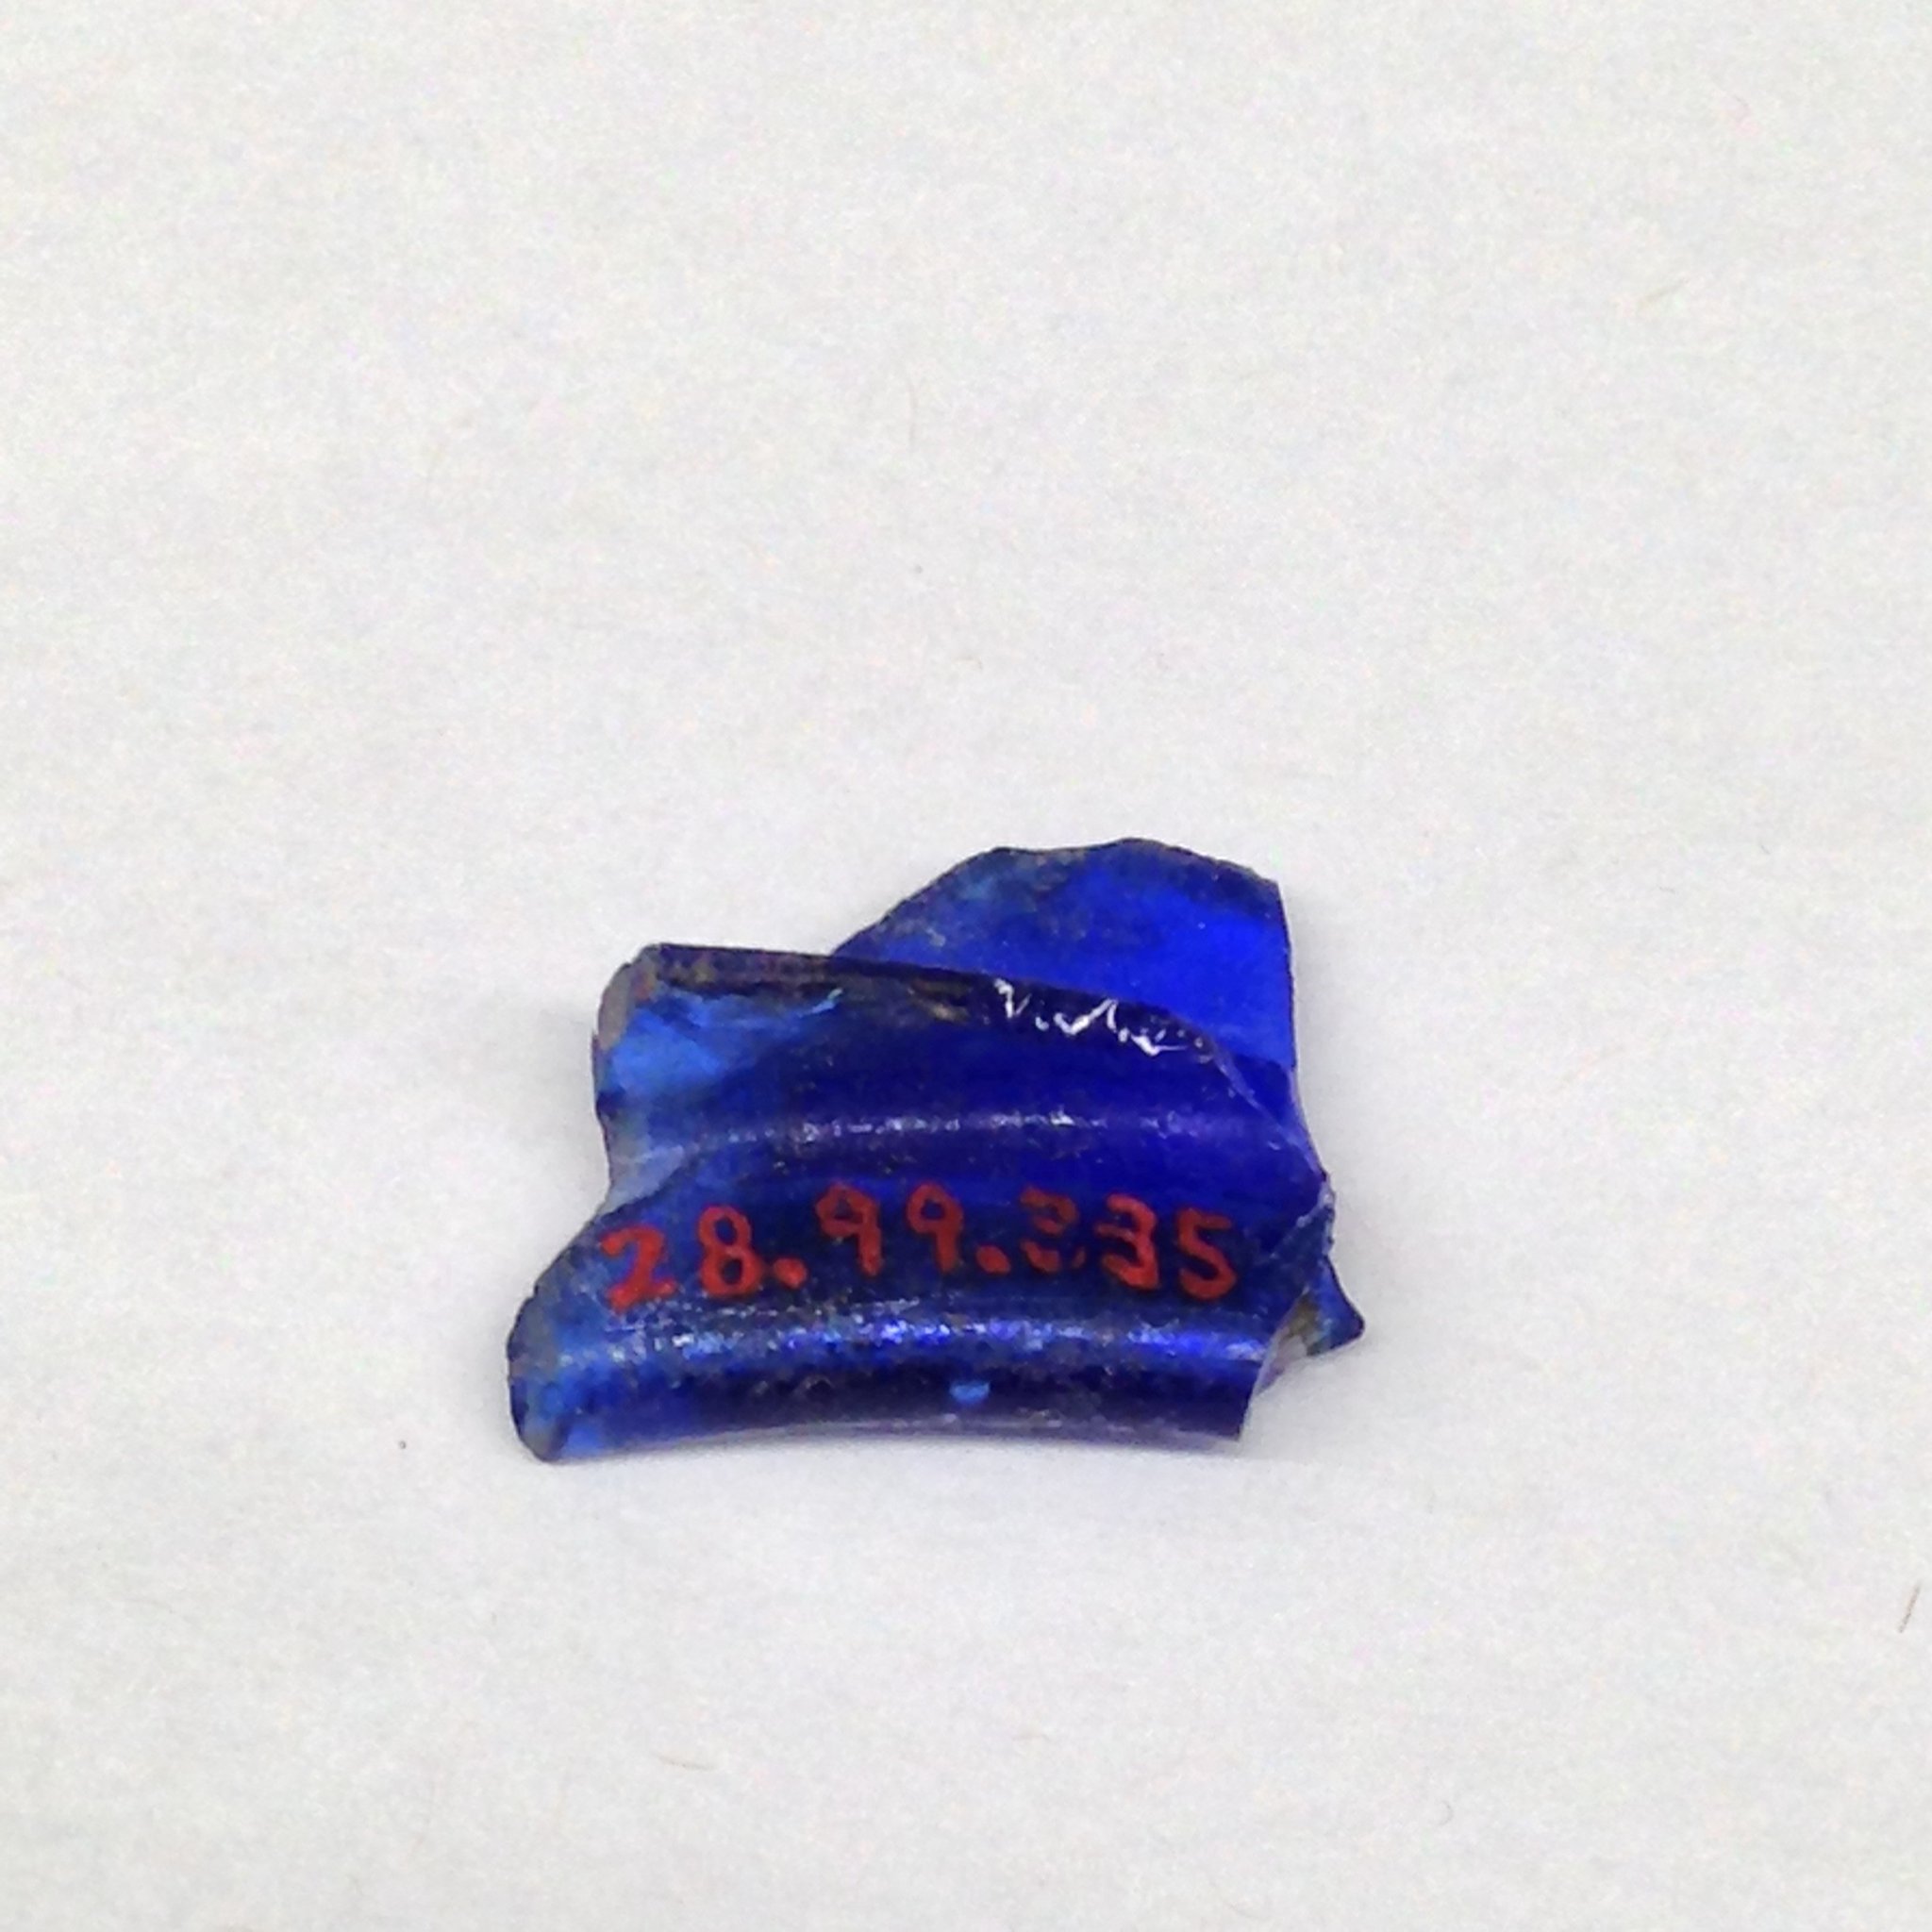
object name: fragment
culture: european or middle eastern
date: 1150-1250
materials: ceramic, glass